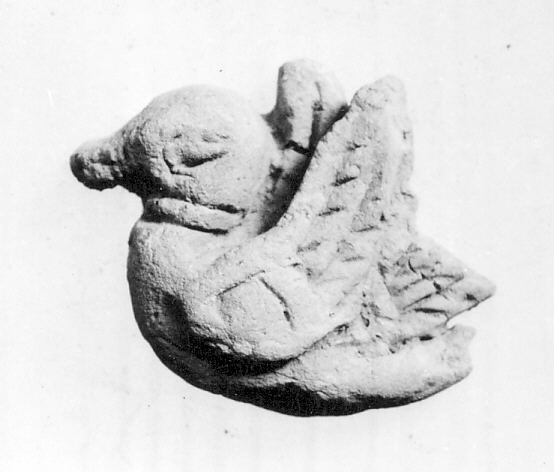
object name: ornament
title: Duck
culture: central asian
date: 1101-1133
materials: clay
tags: ducks